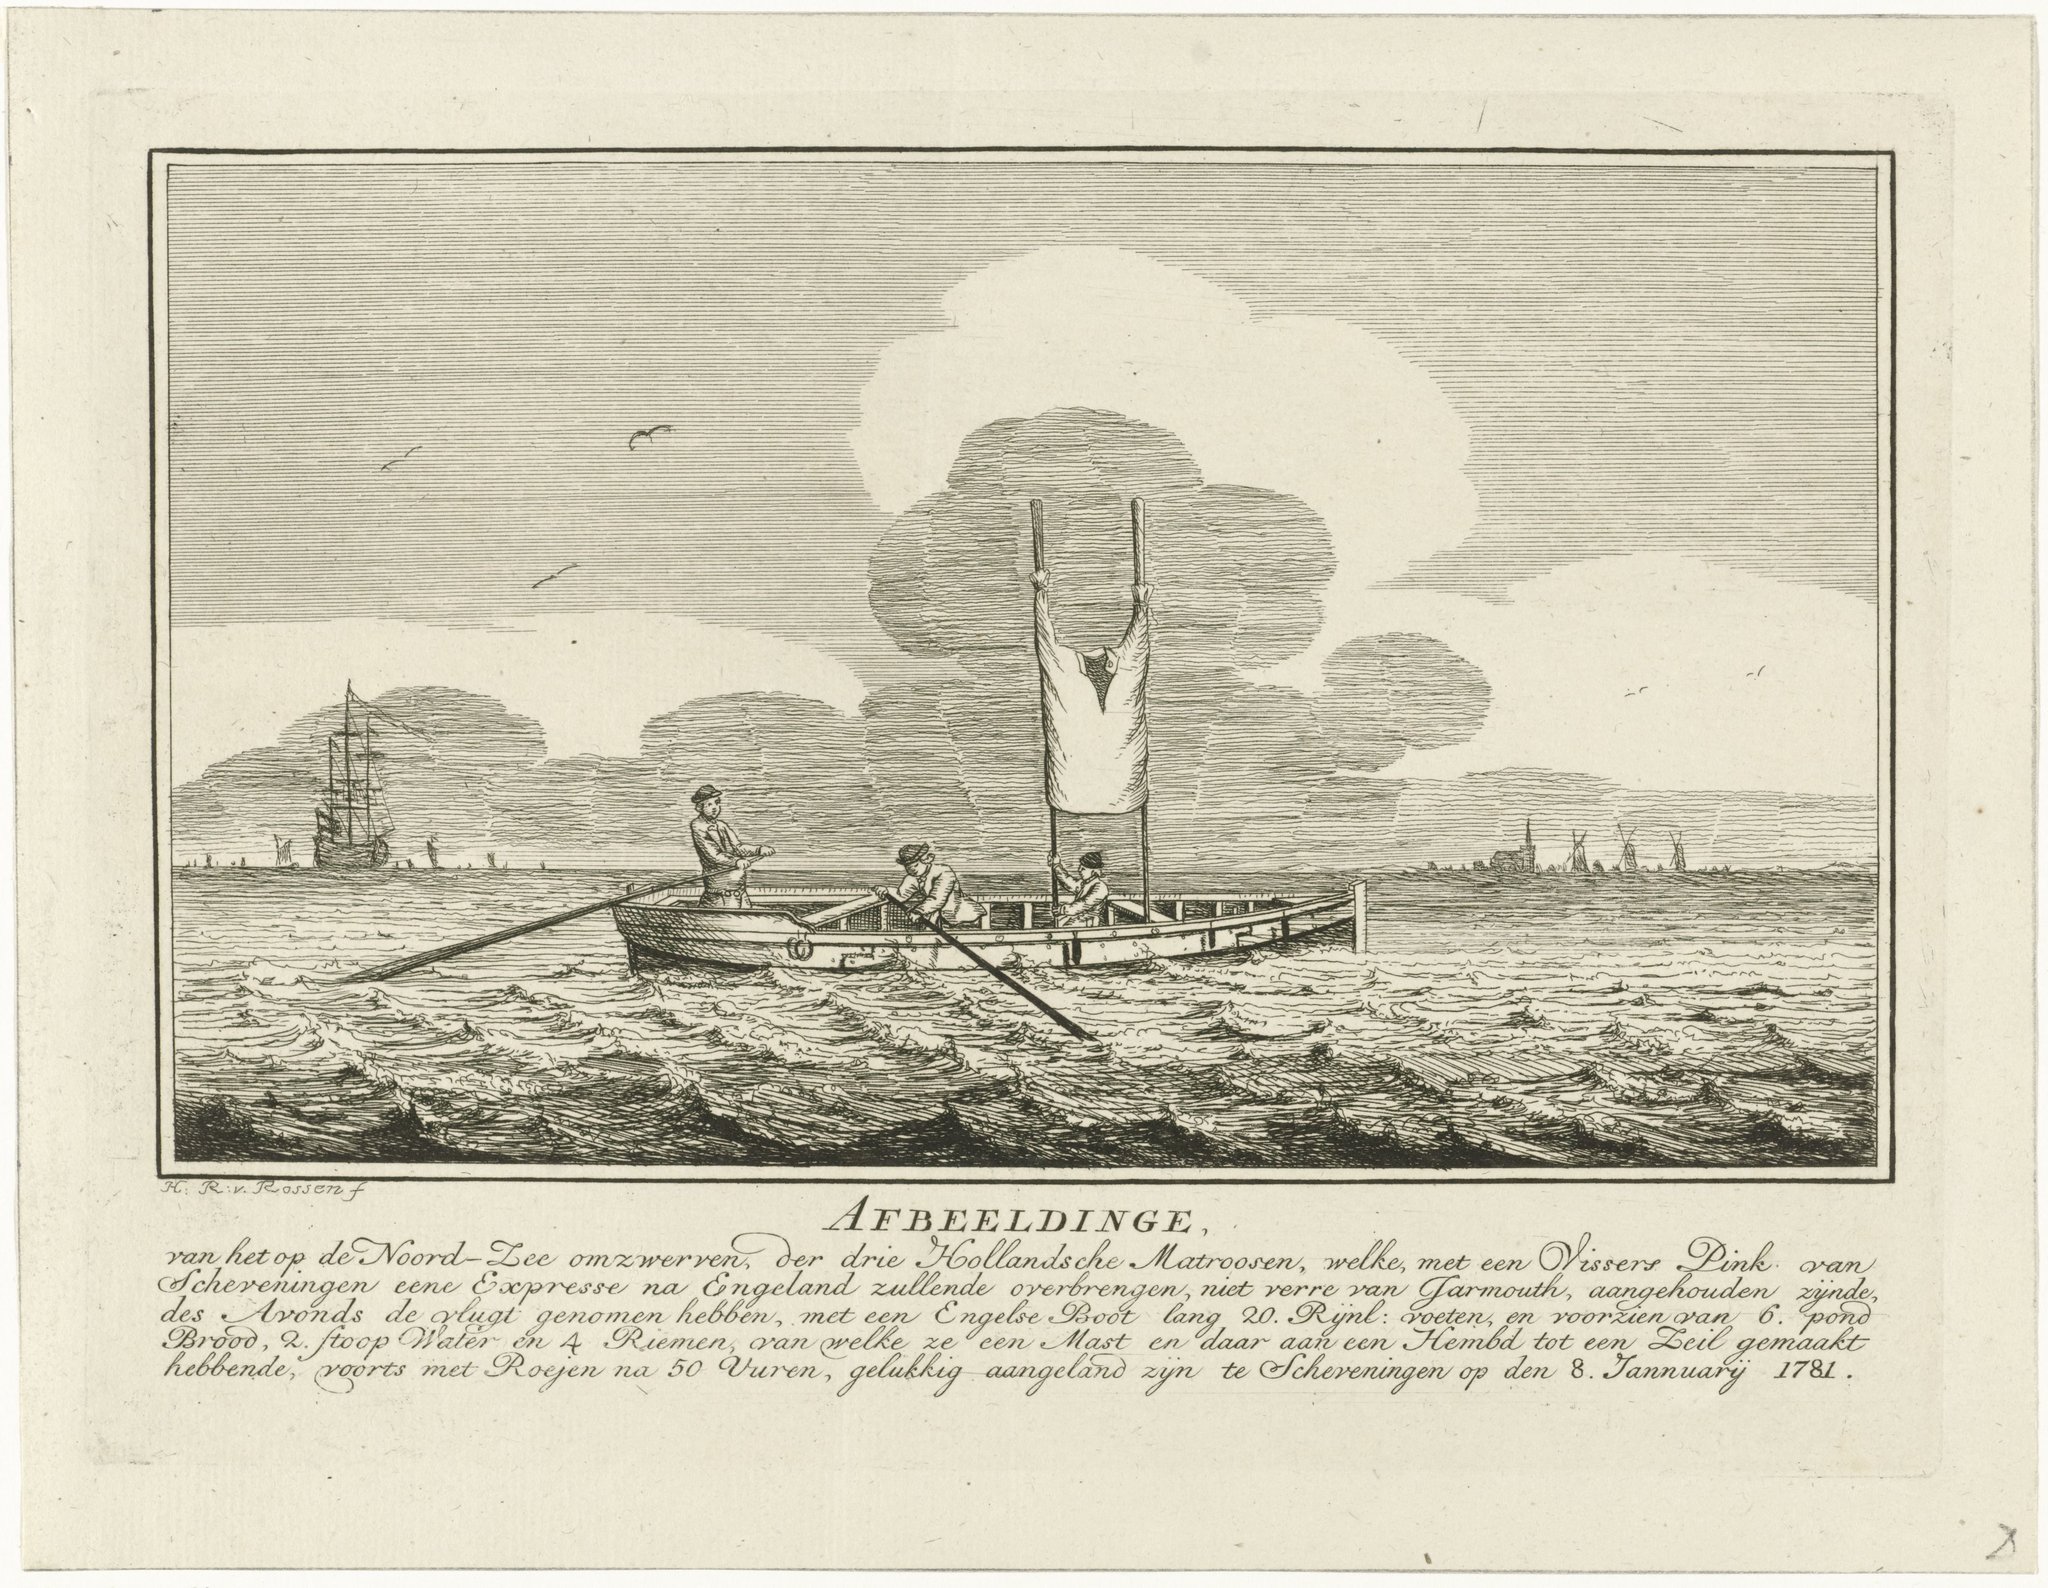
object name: print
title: Afbeeldinge, van het op de Noord-Zee omzwerven, der drie Hollandsche Matroosen (...) gelukkig aangeland te Scheveningen 8 Jannuarij 1781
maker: hendrik r. van rossen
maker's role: print maker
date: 1781-1783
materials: paper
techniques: etching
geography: netherlands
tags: escape, escape attempts, rowing-boat, canoe, etc., fourth anglo-dutch war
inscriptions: collector's mark: Lugt 2228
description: De aankomst van drie uit Engeland gevluchte Hollandse matrozen bij de kust bij Scheveningen op 8 januari 1781. De matrozen ontvluchtten een aanhouding in Yarmouth en roeiden in een visserspink terug naar Nederland.